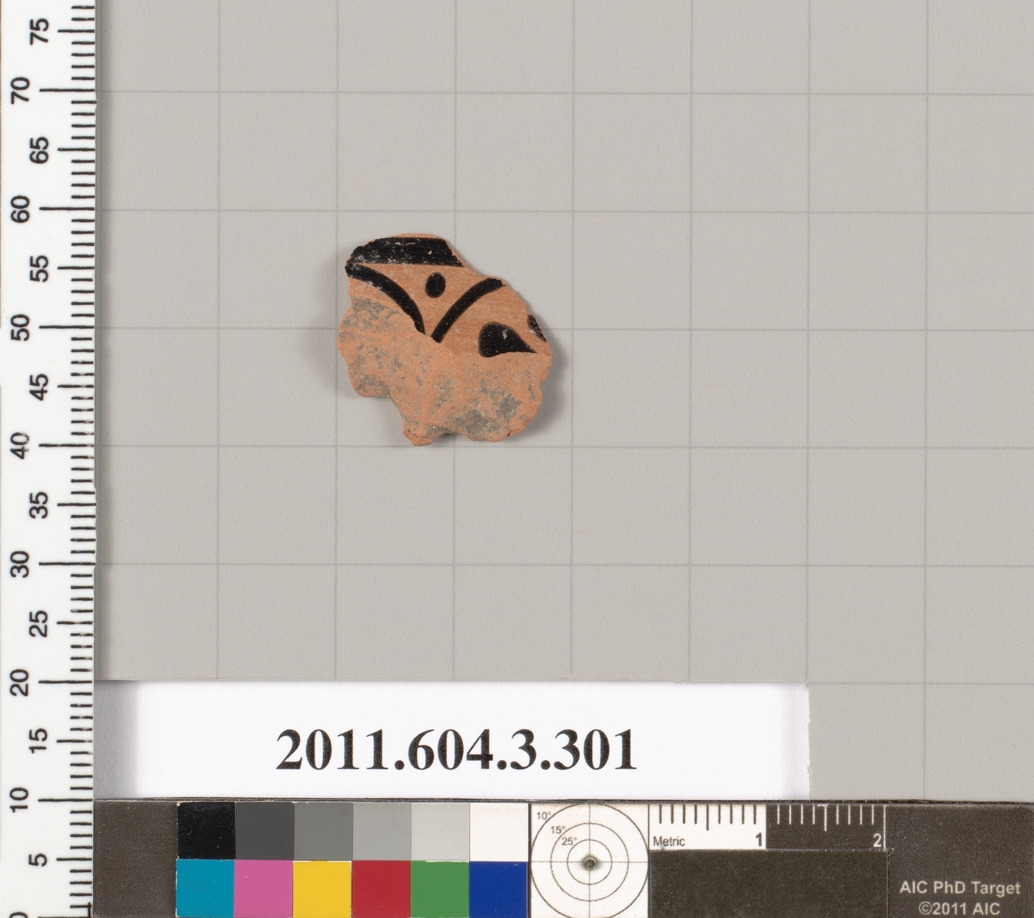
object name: neck amphora fragment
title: Terracotta fragment of a neck-amphora (jar)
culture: greek, attic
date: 534-468 BCE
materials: terracotta